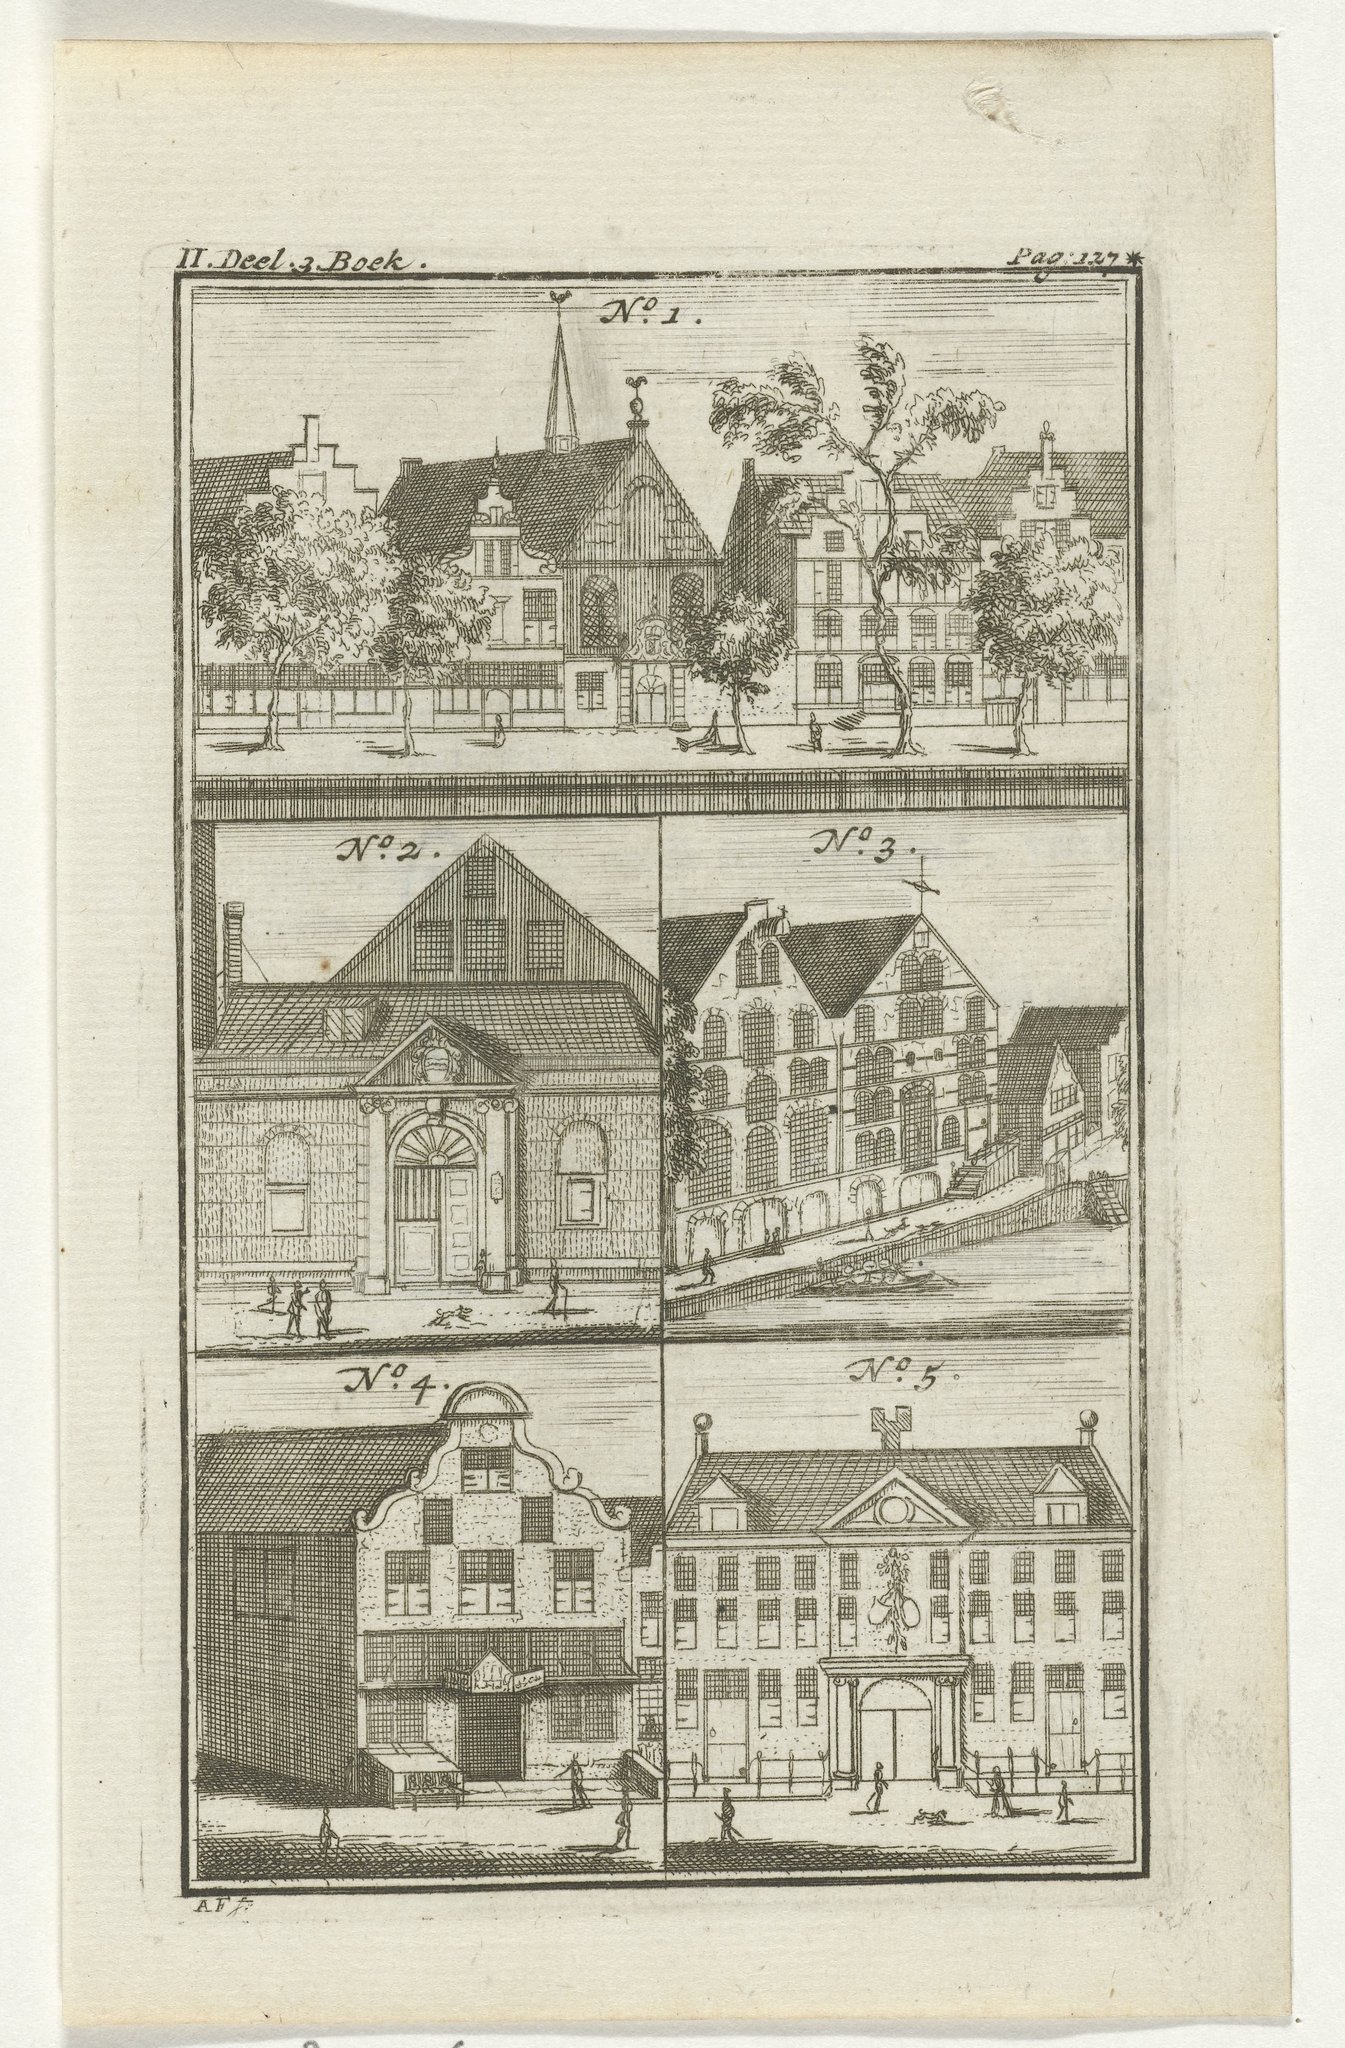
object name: text sheet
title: Tekstblad bij boekillustratie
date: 1723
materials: paper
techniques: letterpress printing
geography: amsterdam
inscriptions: collector's mark: Lugt 2760, collector's mark: Lugt 2228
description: Tekstblad uit: Leuve, Roeland van. 's Waerelds koopslot of De Amsteldamse beurs. Amsterdam: Jacobus Verheyden (I), 1723.